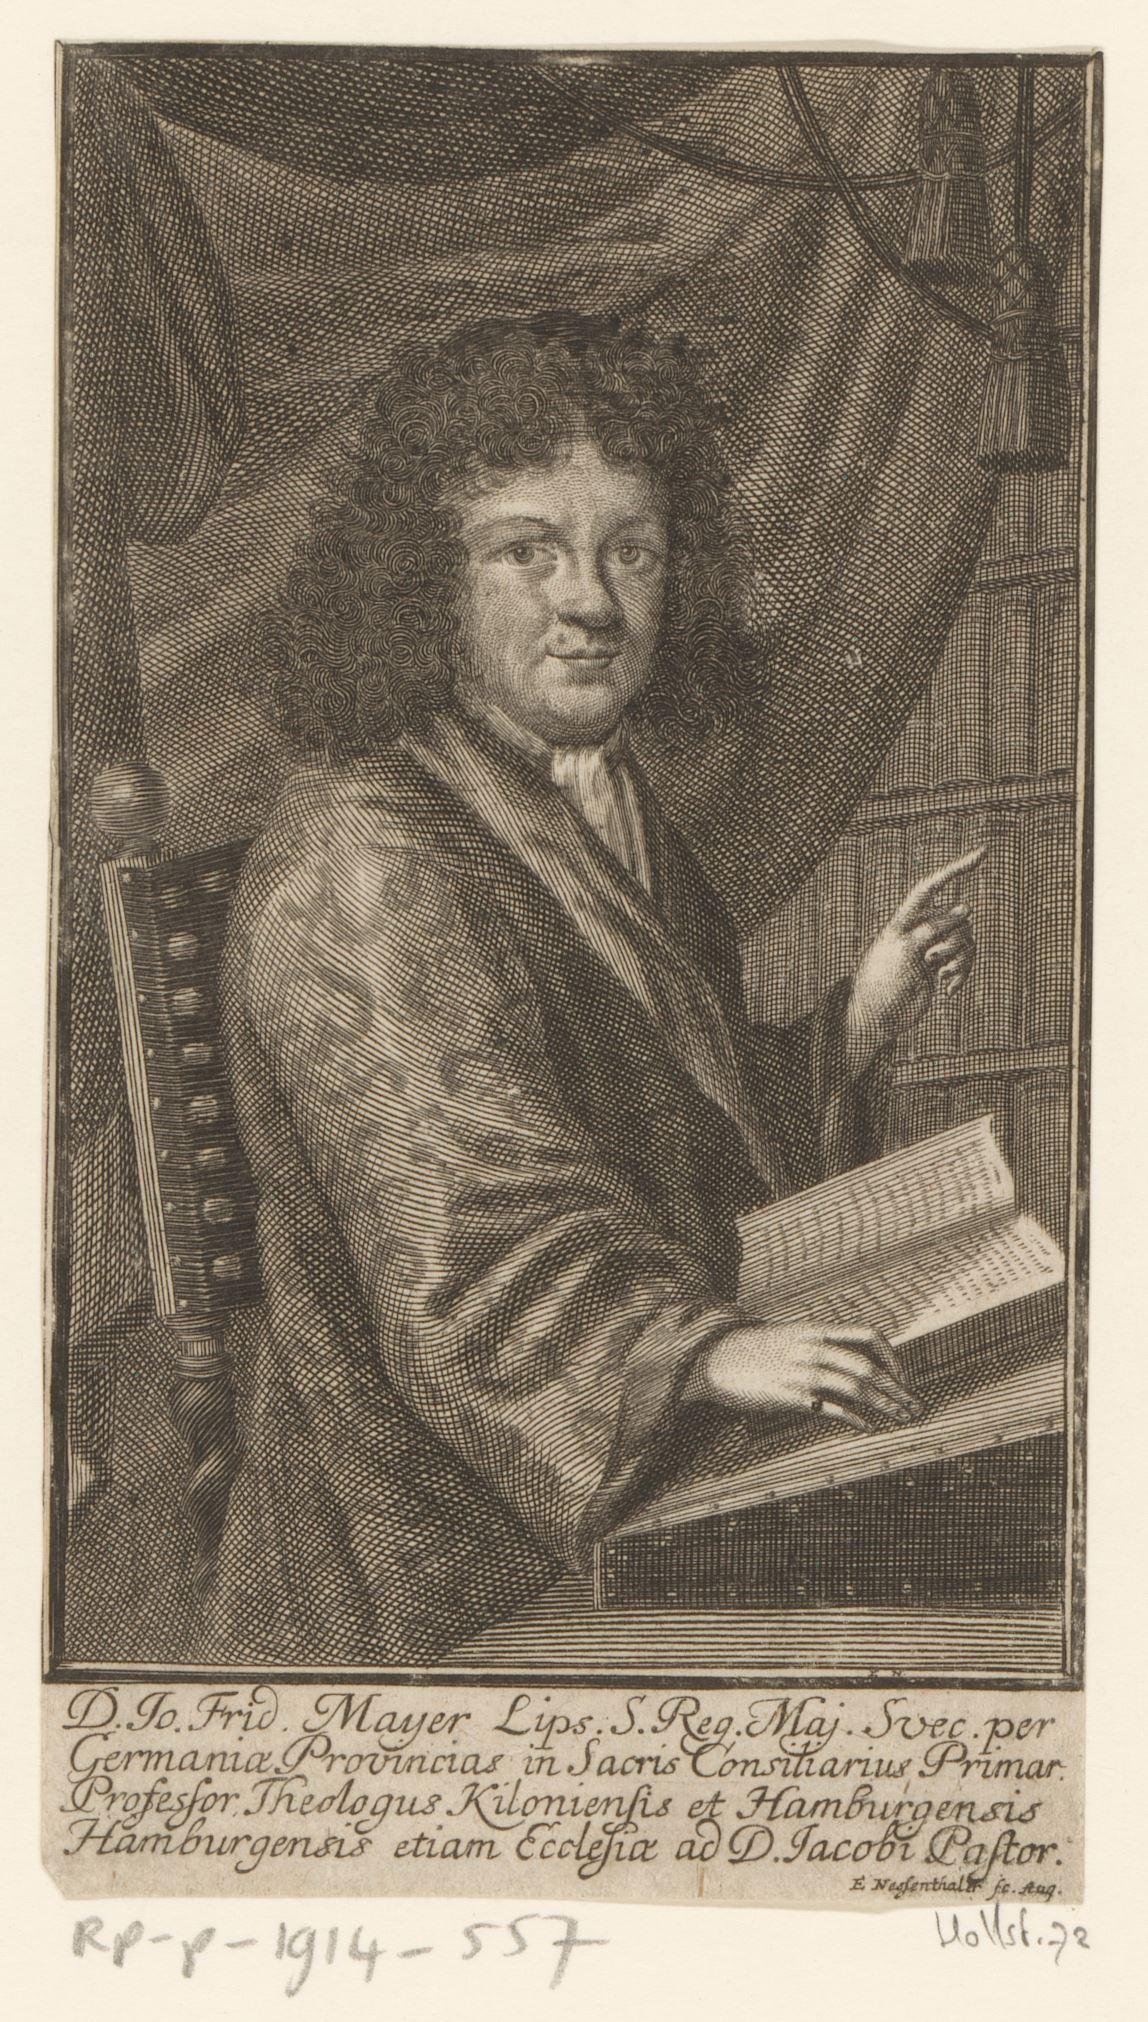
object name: print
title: Portret van Johann Friedrich Mayer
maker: elias nessenthaler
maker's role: print maker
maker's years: 1664-1714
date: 1674-1714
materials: paper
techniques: engraving, etching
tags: bookshelves, historical persons, book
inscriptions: collector's mark: Lugt 2228